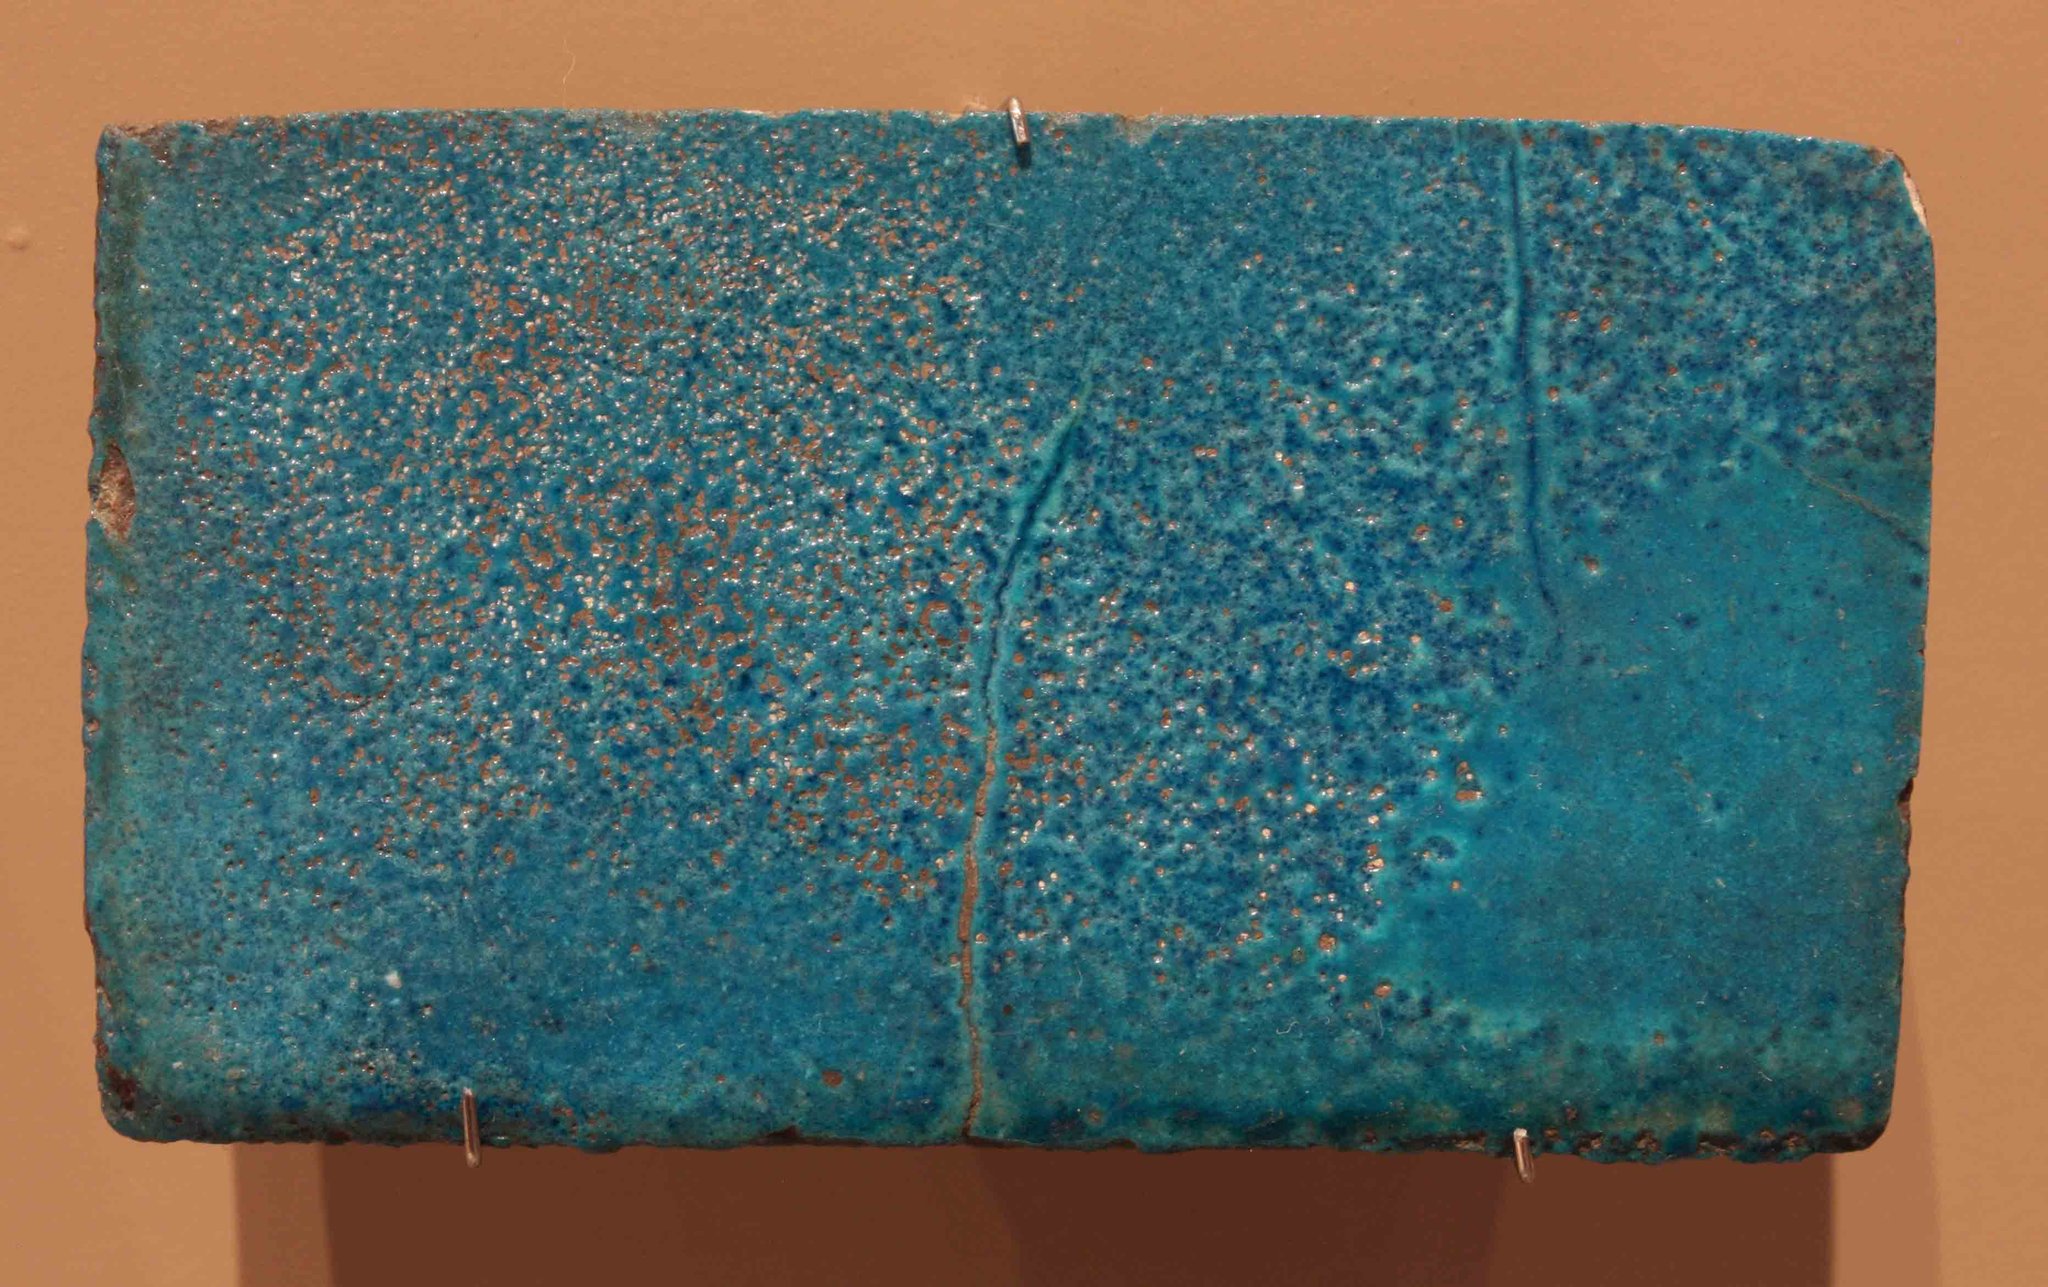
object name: tile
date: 1550-1295 BCE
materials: faience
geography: egypt